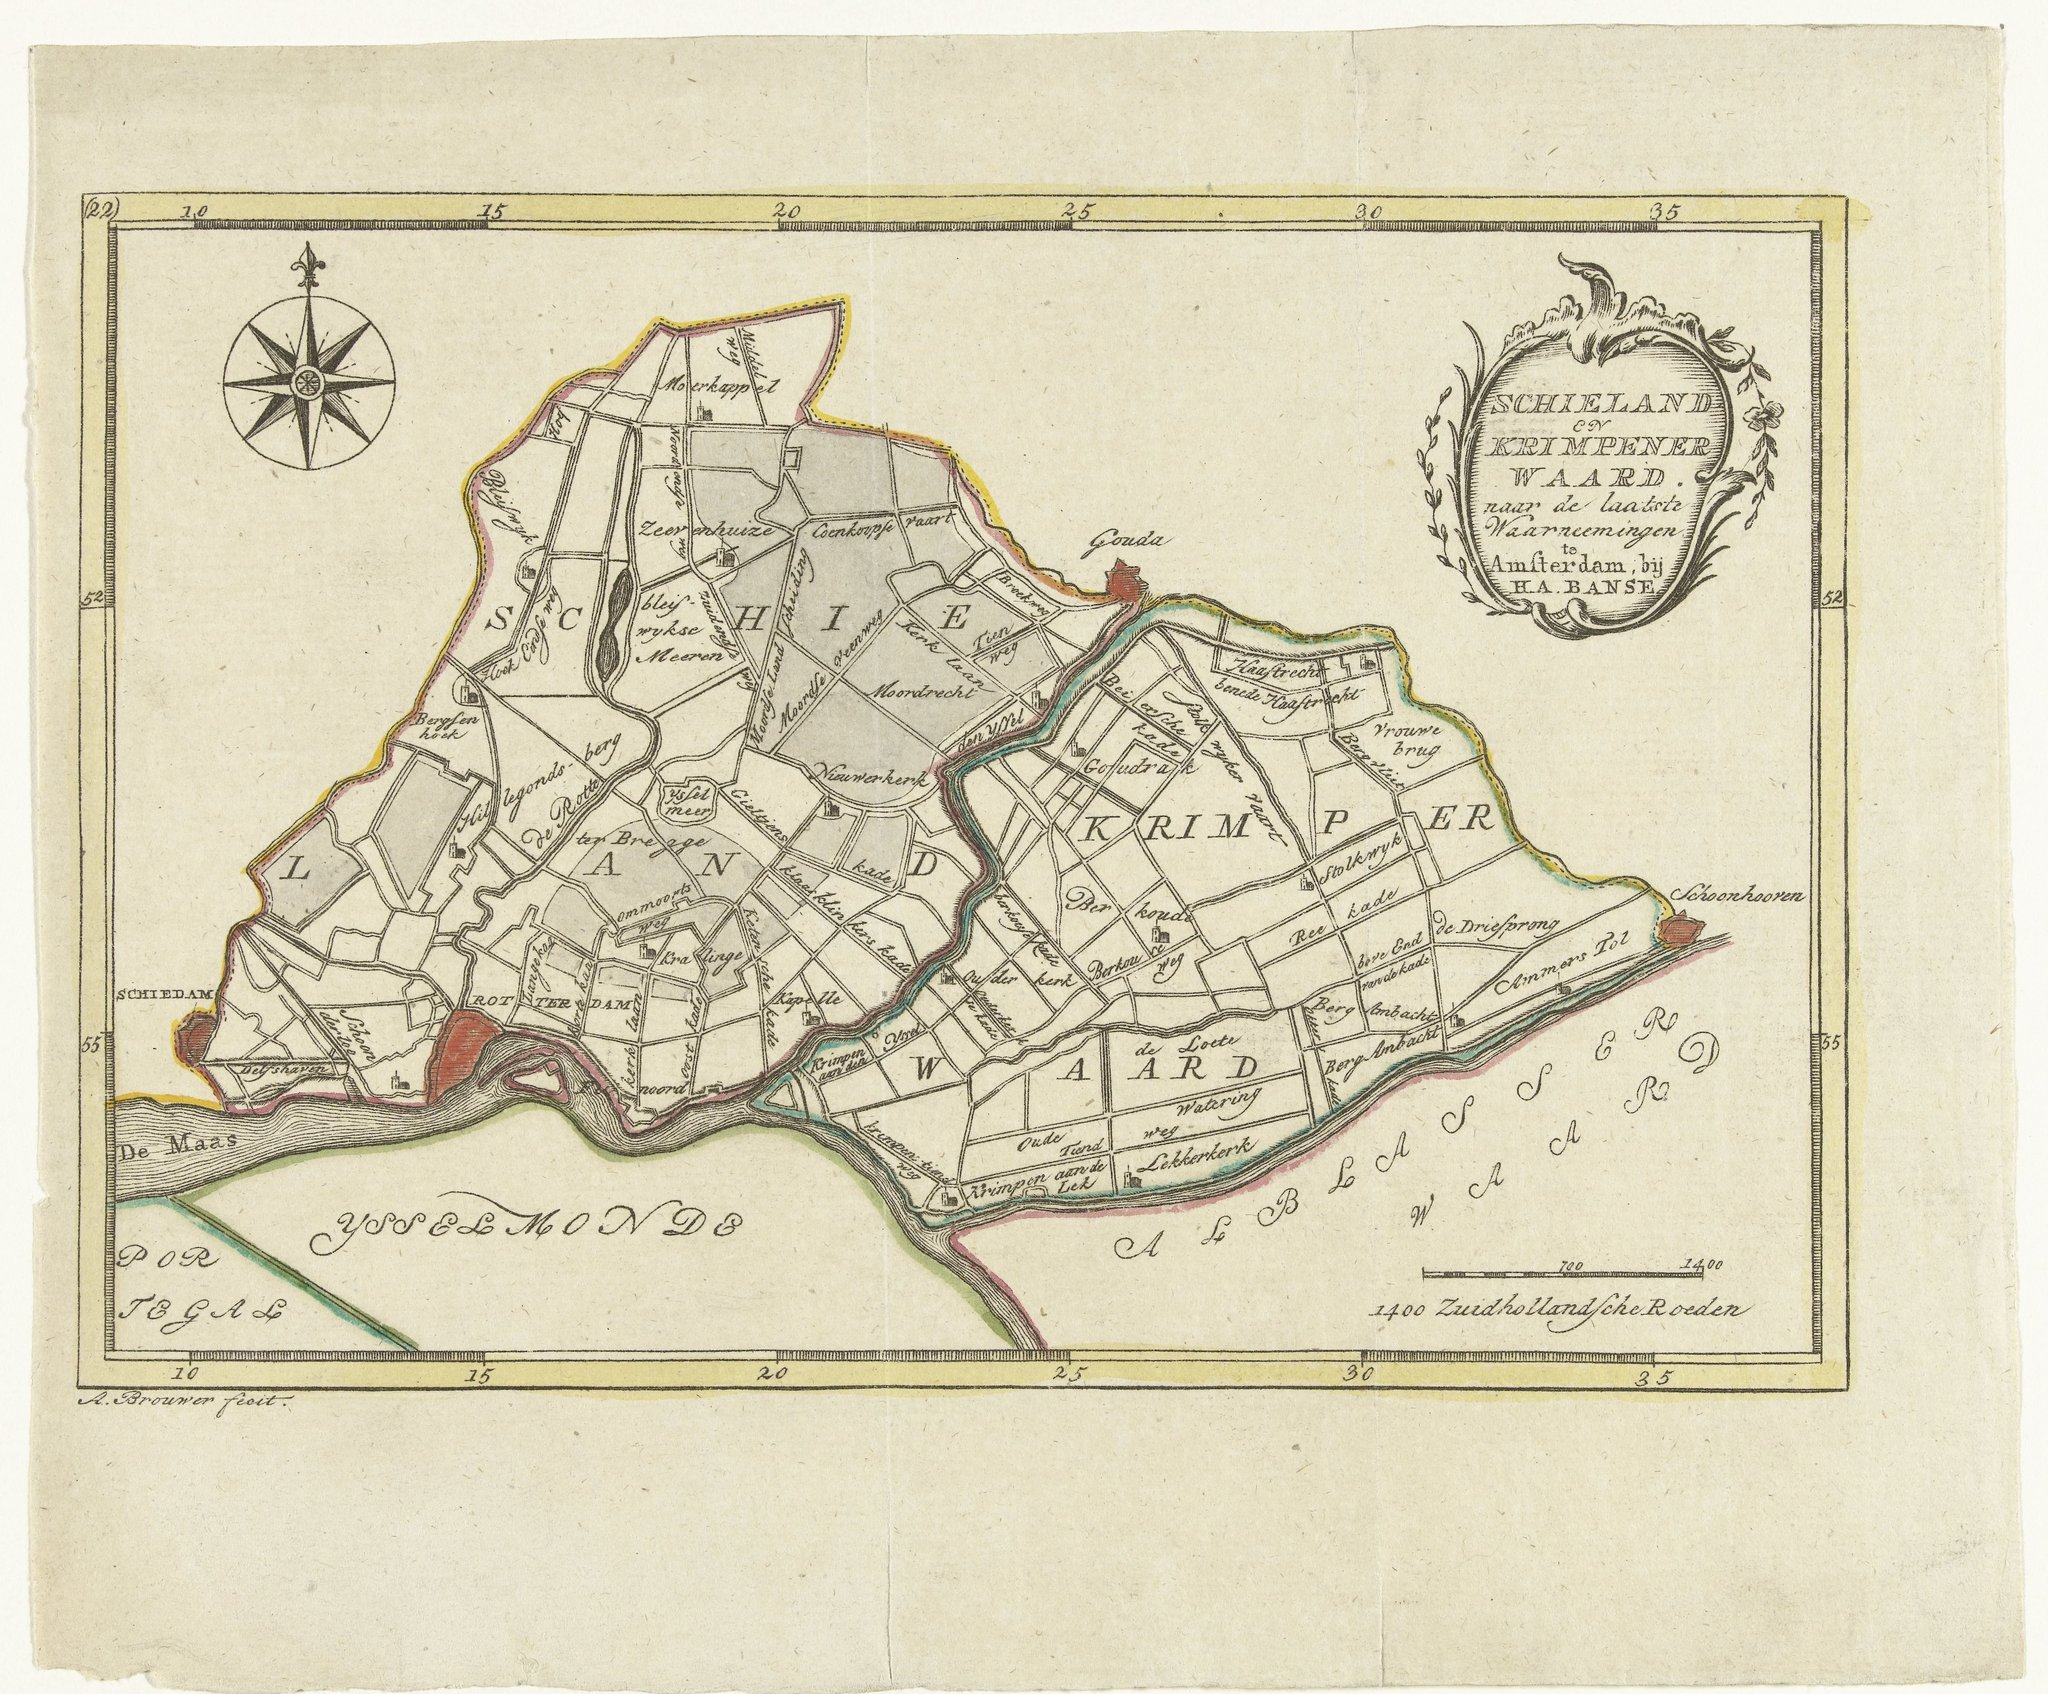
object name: print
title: Kaart van Schieland en Krimpenerwaard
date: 1797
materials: paper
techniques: etching, hand coloring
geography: amsterdam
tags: maps, atlases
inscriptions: collector's mark: Lugt 2228, collector's mark: Lugt 2760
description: afkomstig uit: L. van Ollefen, De Nederlandsche stad- en dorpbeschrijver. Deel 5. Amsterdam: H.A. Banse, 1797